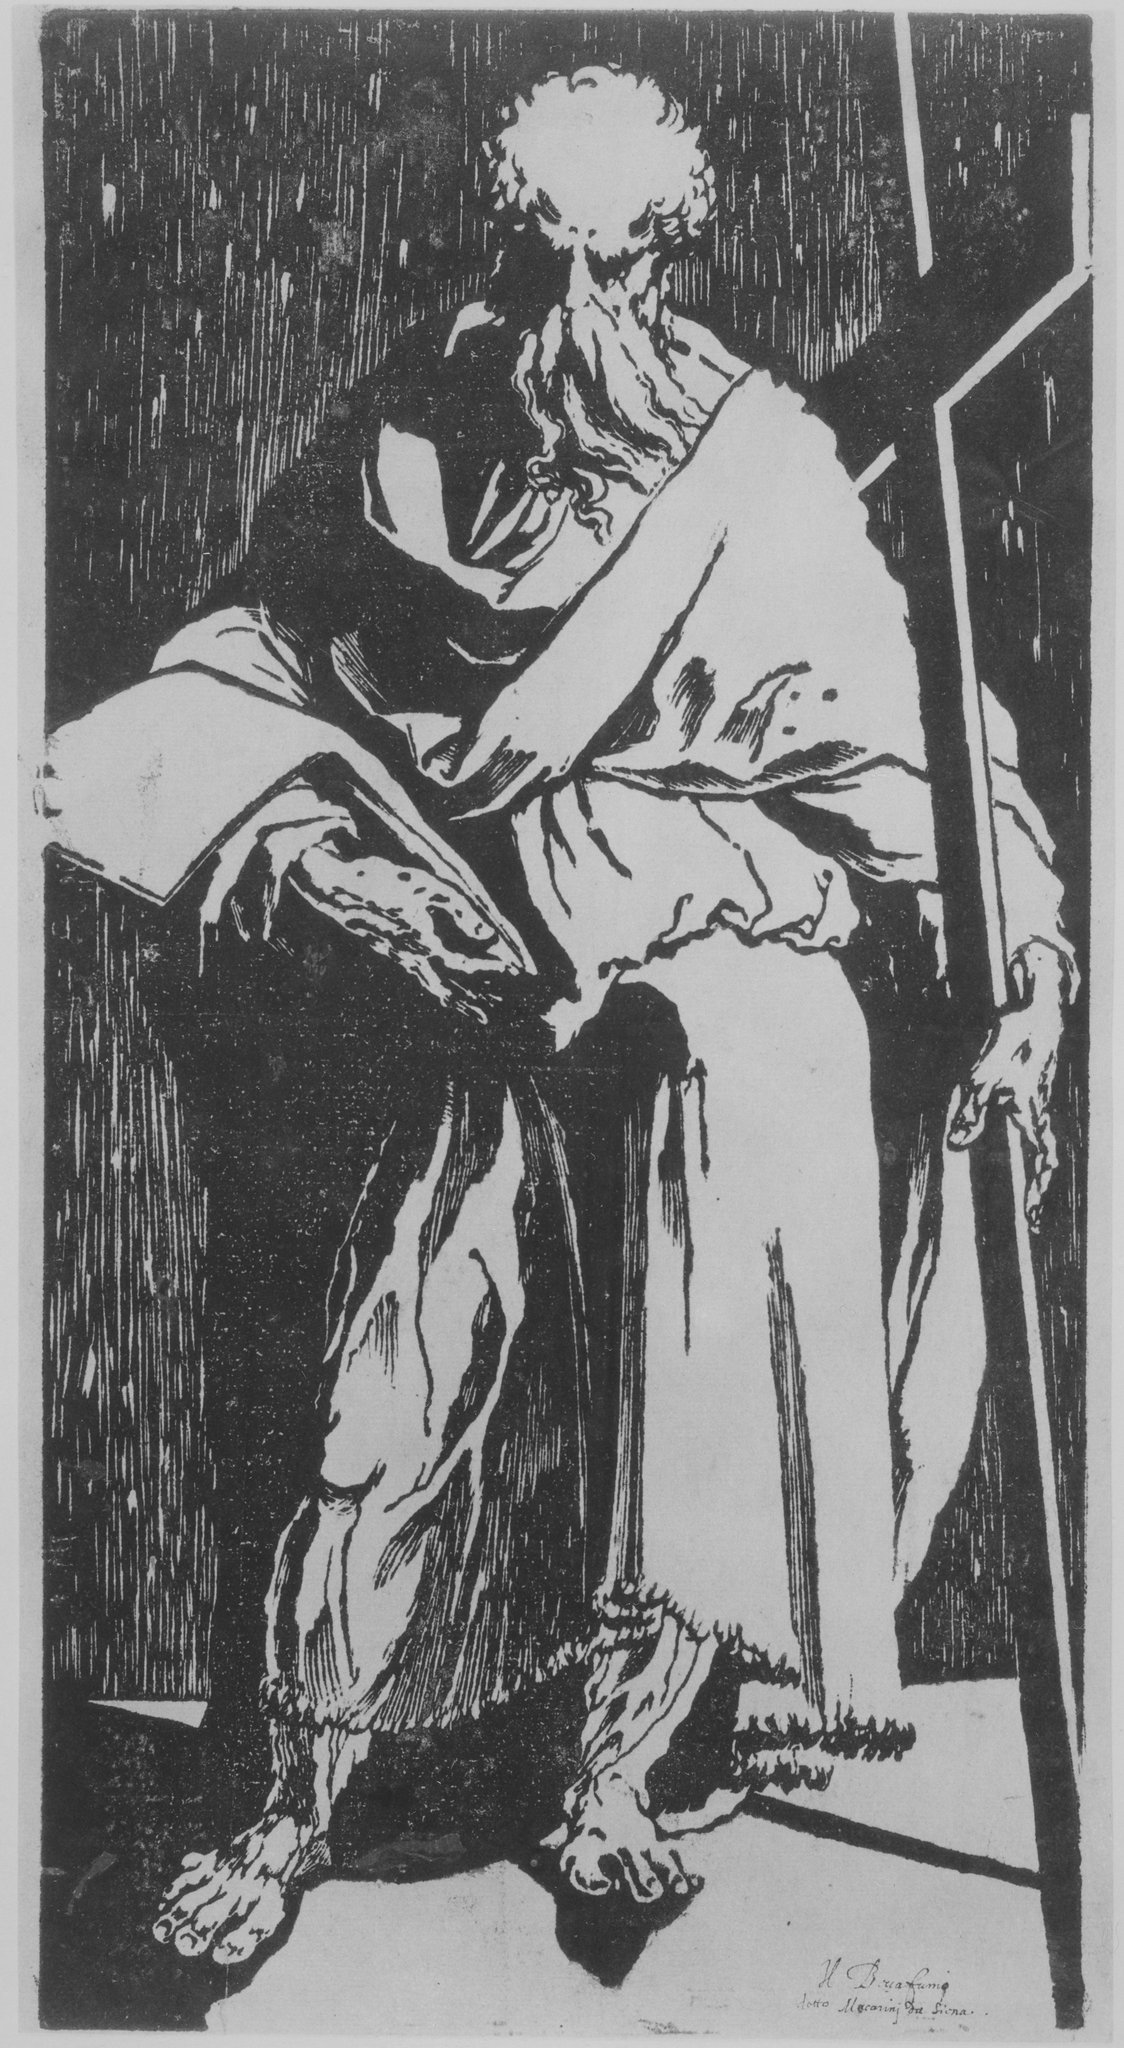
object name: print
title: Saint Philip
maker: domenico beccafumi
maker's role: artist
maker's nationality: italian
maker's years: 1484-1551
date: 1540-1550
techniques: woodcut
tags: men,apostles,cross,saints